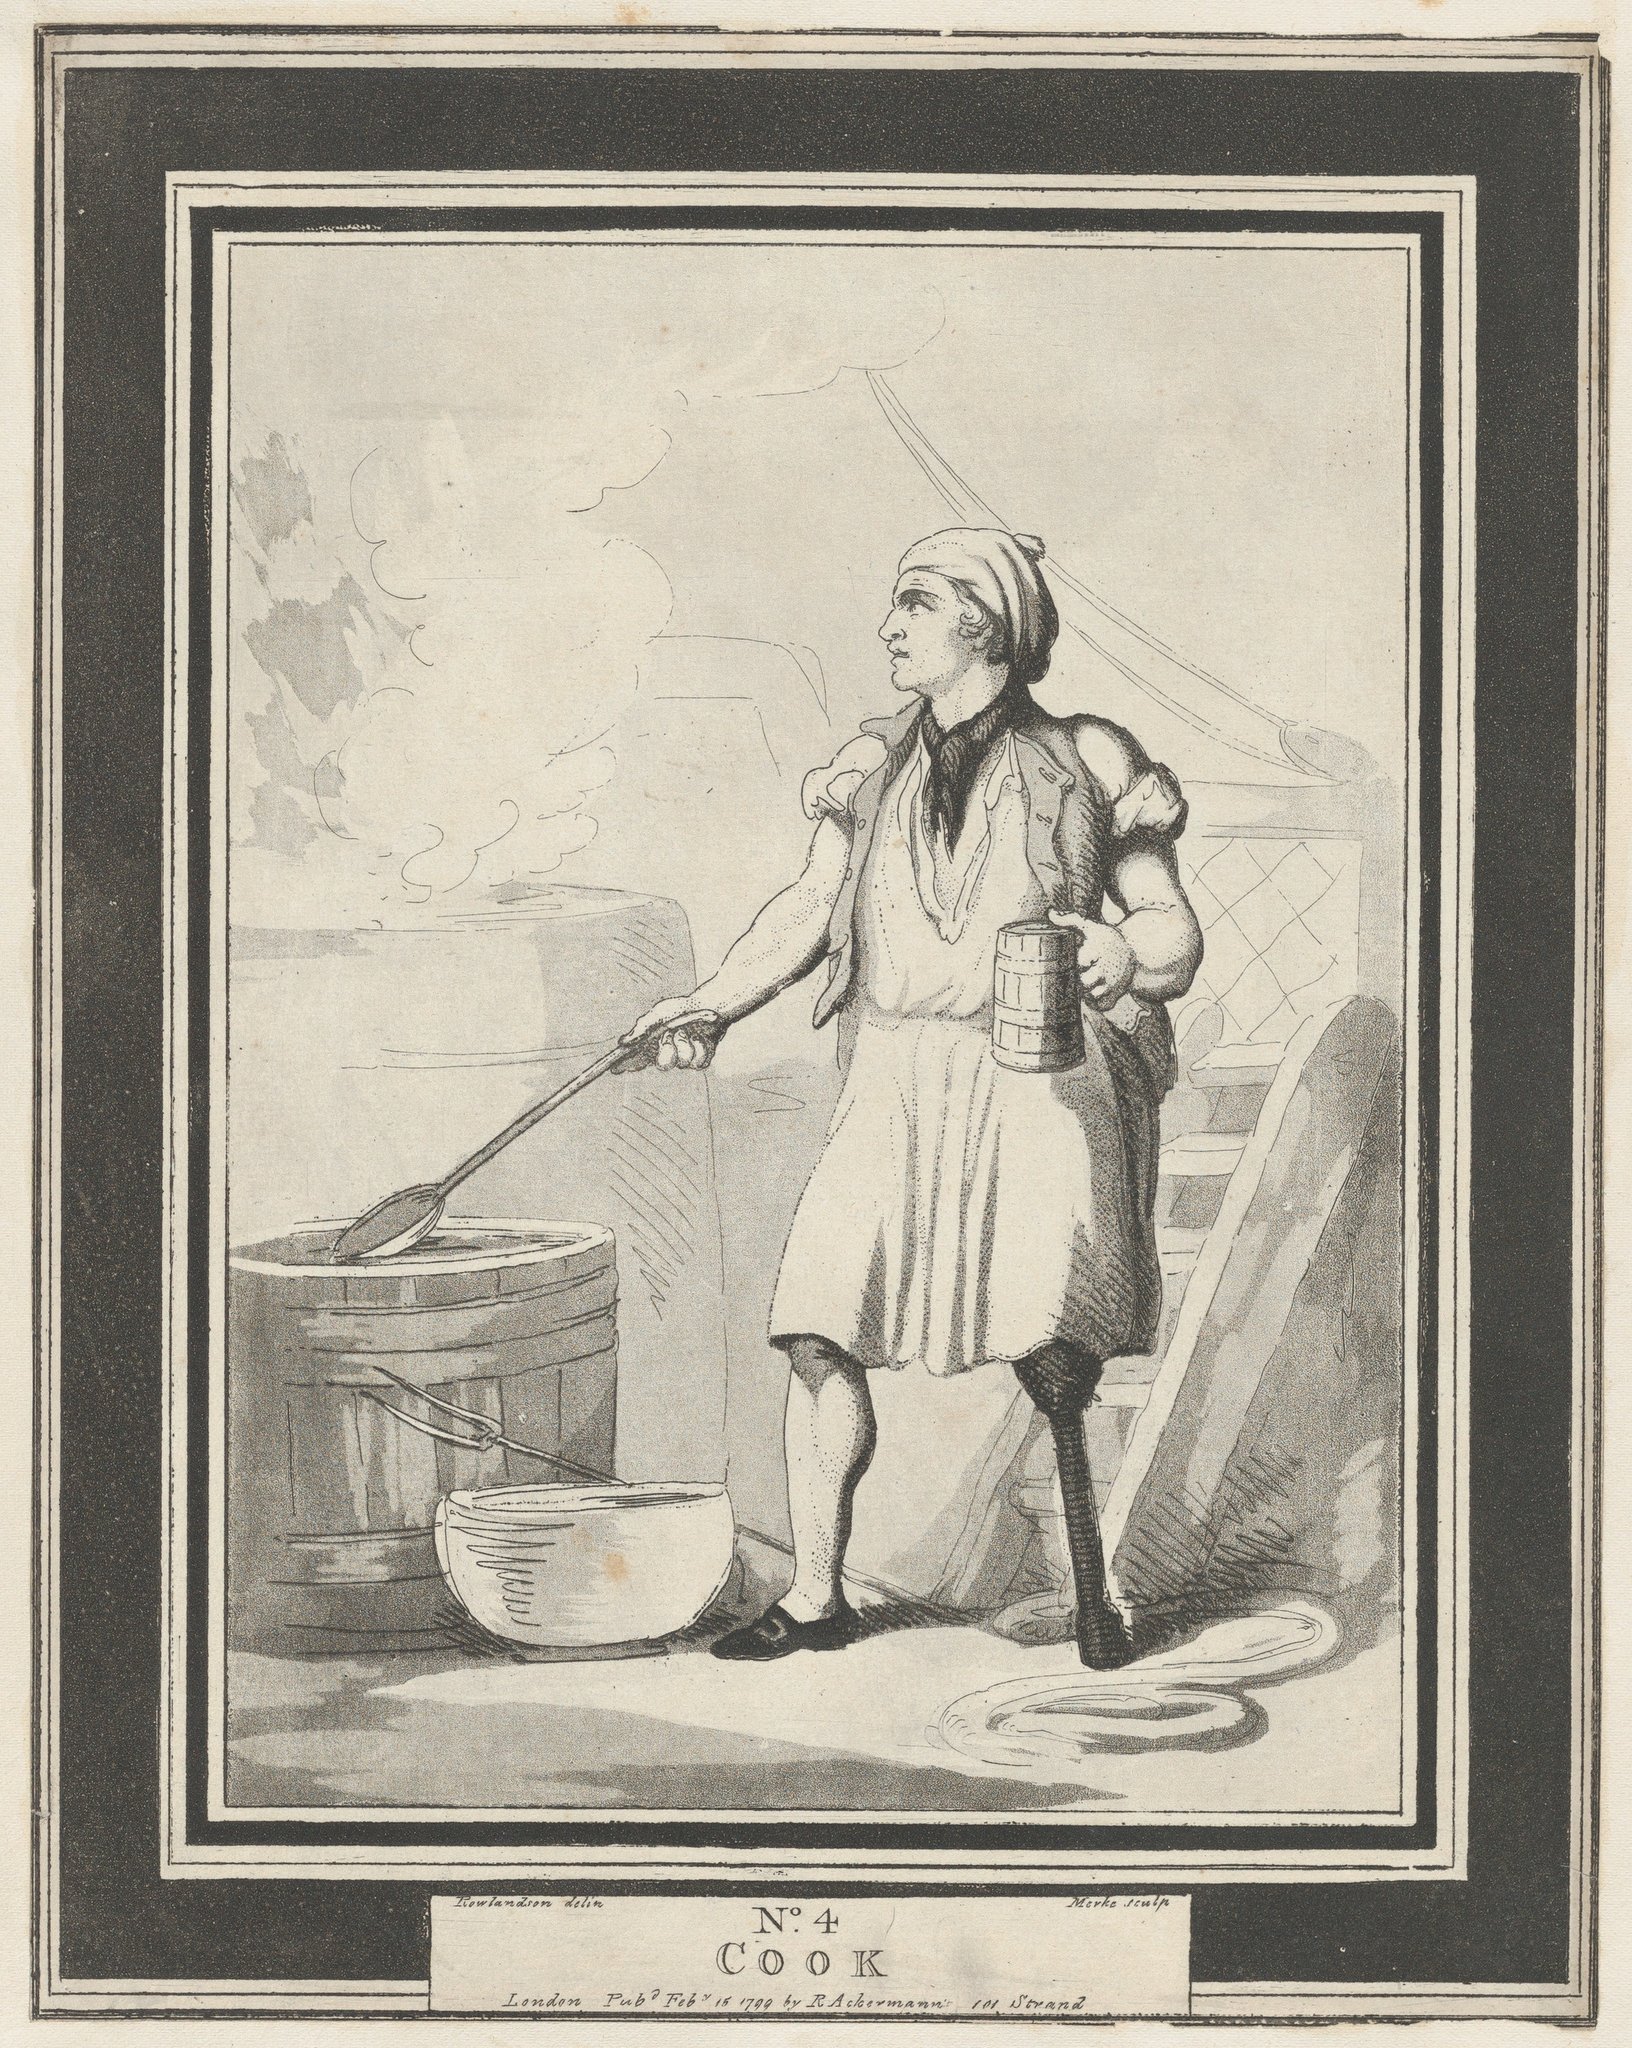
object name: print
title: No. 4: Cook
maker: henri merke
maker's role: etcher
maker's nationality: swiss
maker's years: 1760-1820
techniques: aquatint, etching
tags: men,cooking